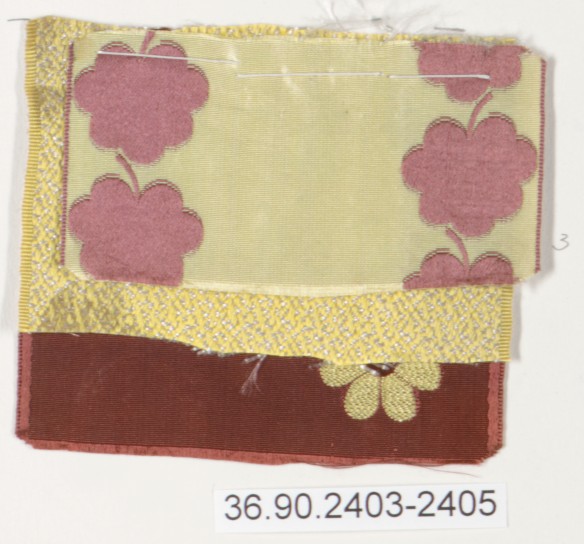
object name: ribbon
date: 1801-1900